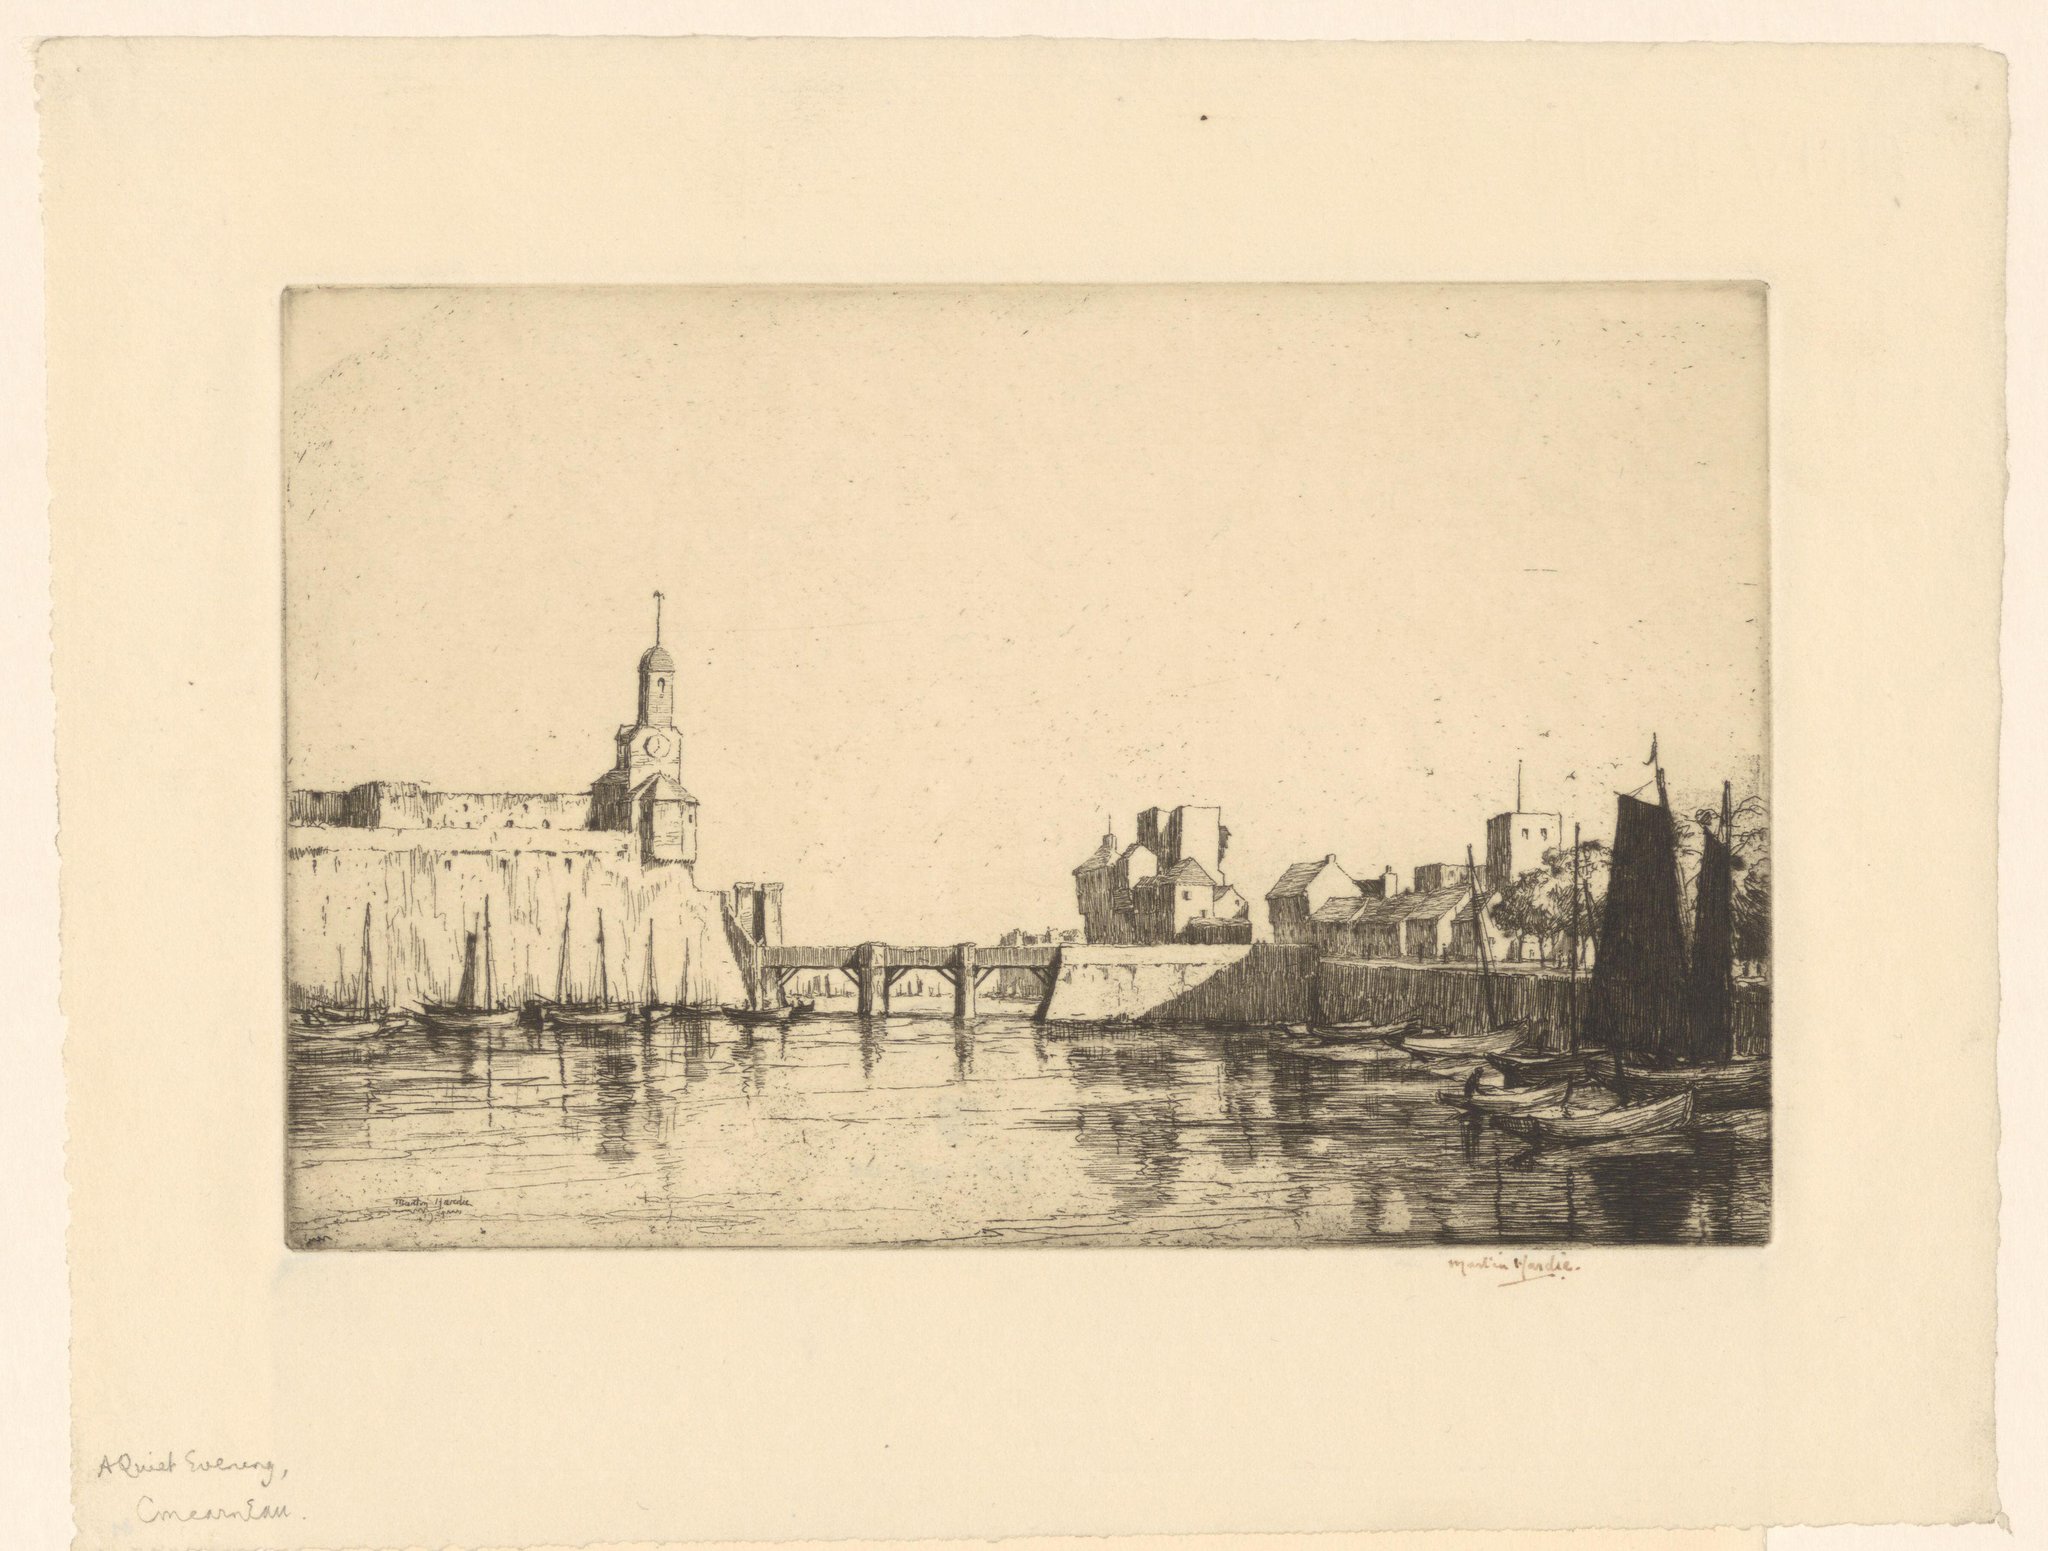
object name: print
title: Gezicht op de Concarneau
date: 1921-1926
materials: paper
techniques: etching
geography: concarneau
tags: city-view in general; 'veduta', pier, quay, wharf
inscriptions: annotation: ‘Martin Hardie’, collector's mark: Lugt 2760, collector's mark: Lugt 2228